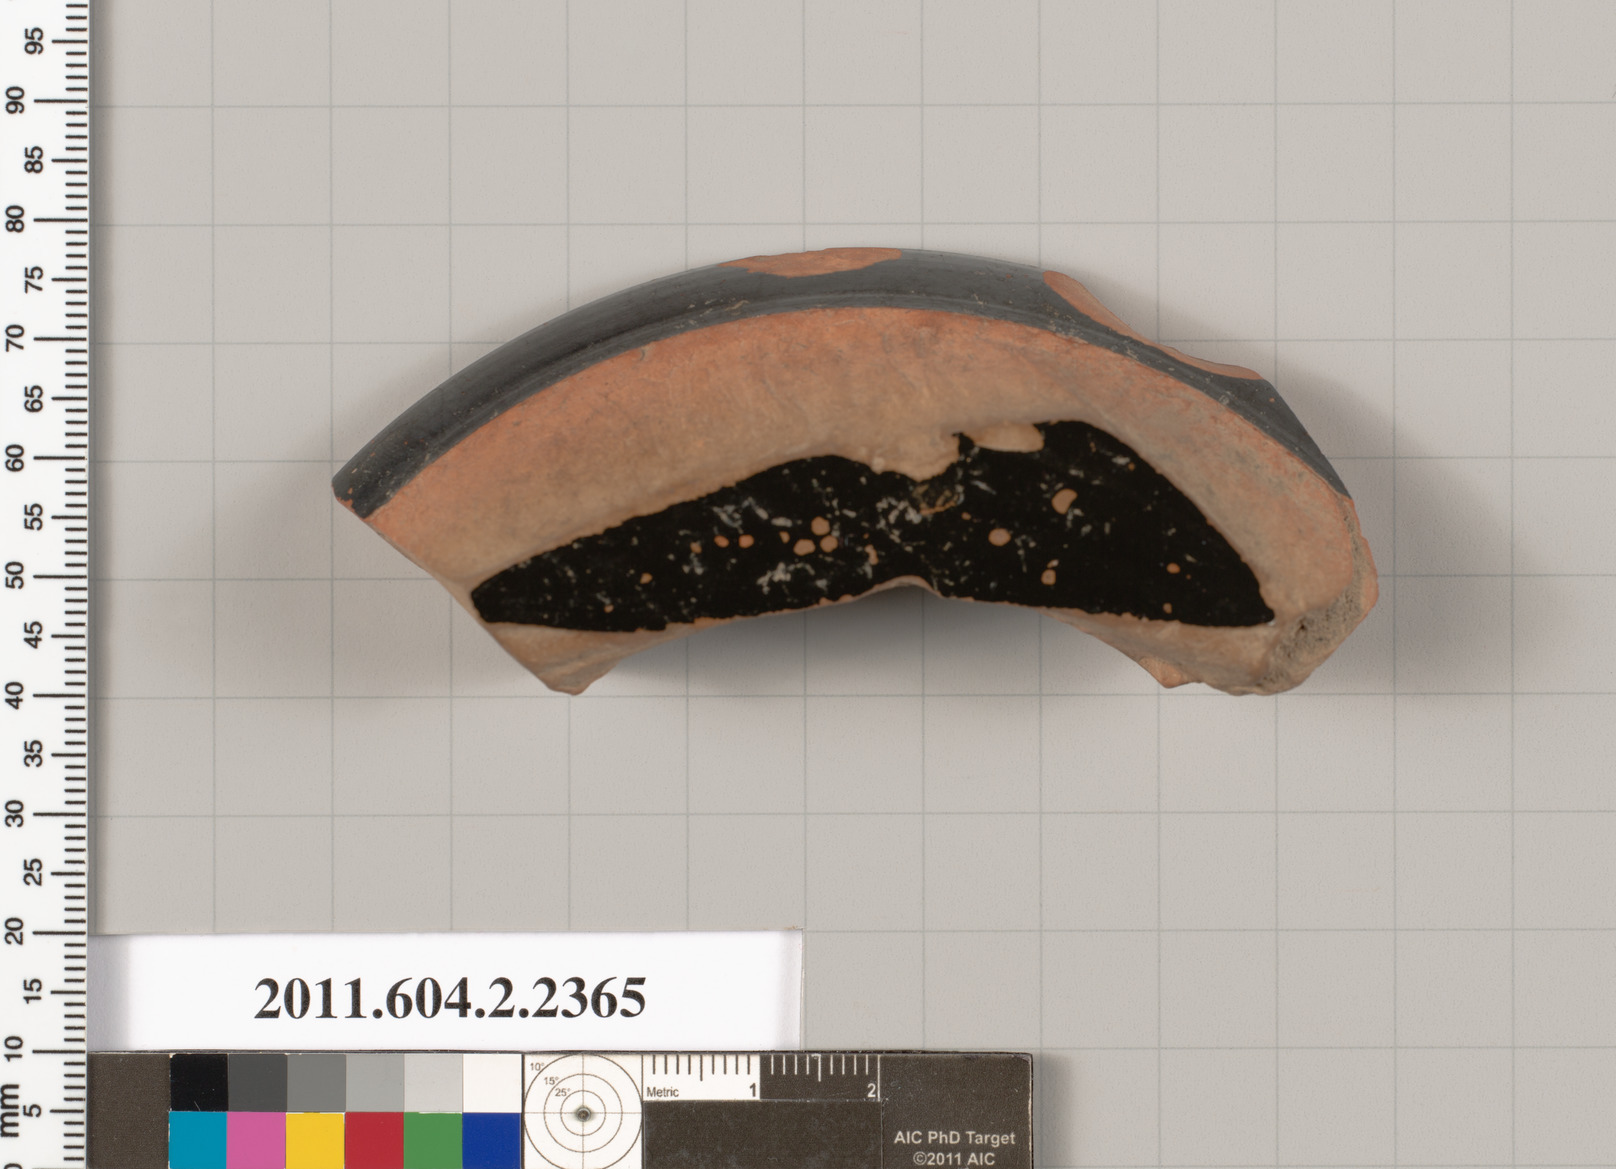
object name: psykter fragment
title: Terracotta fragment of a psykter (vase for cooling wine)?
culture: greek, attic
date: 490-470 BCE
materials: terracotta